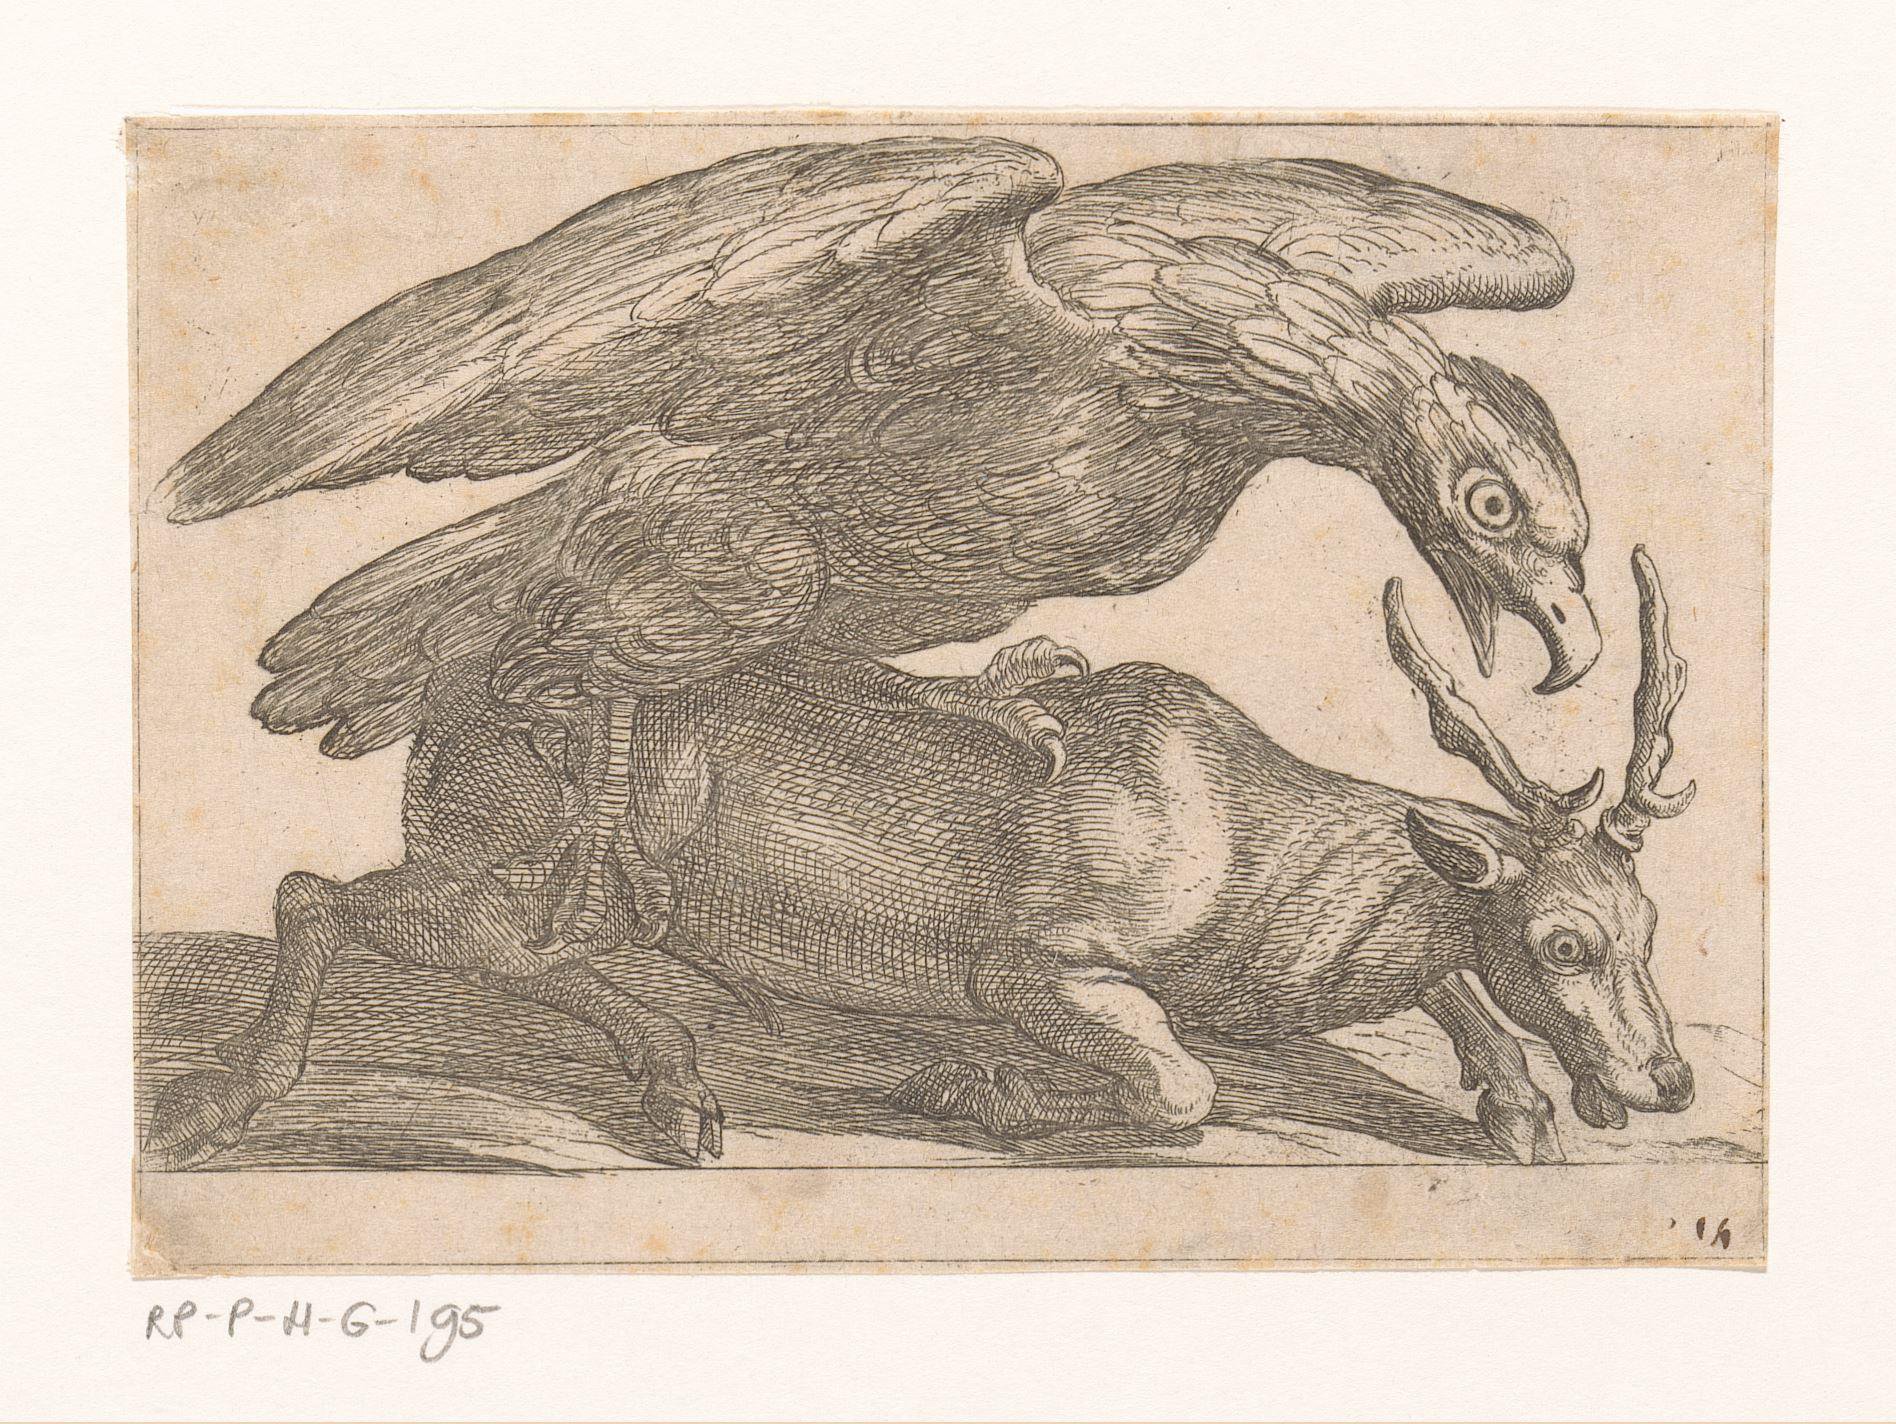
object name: print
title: Een grote vogel valt een hert aan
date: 1600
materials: paper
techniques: etching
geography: rome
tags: birds, hoofed animals: stag, fighting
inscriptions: number: ‘14’, collector's mark: Lugt 2228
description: Deze prent maakt deel uit van een reeks van 25 prenten (+ titelprent) van vechtende dieren.